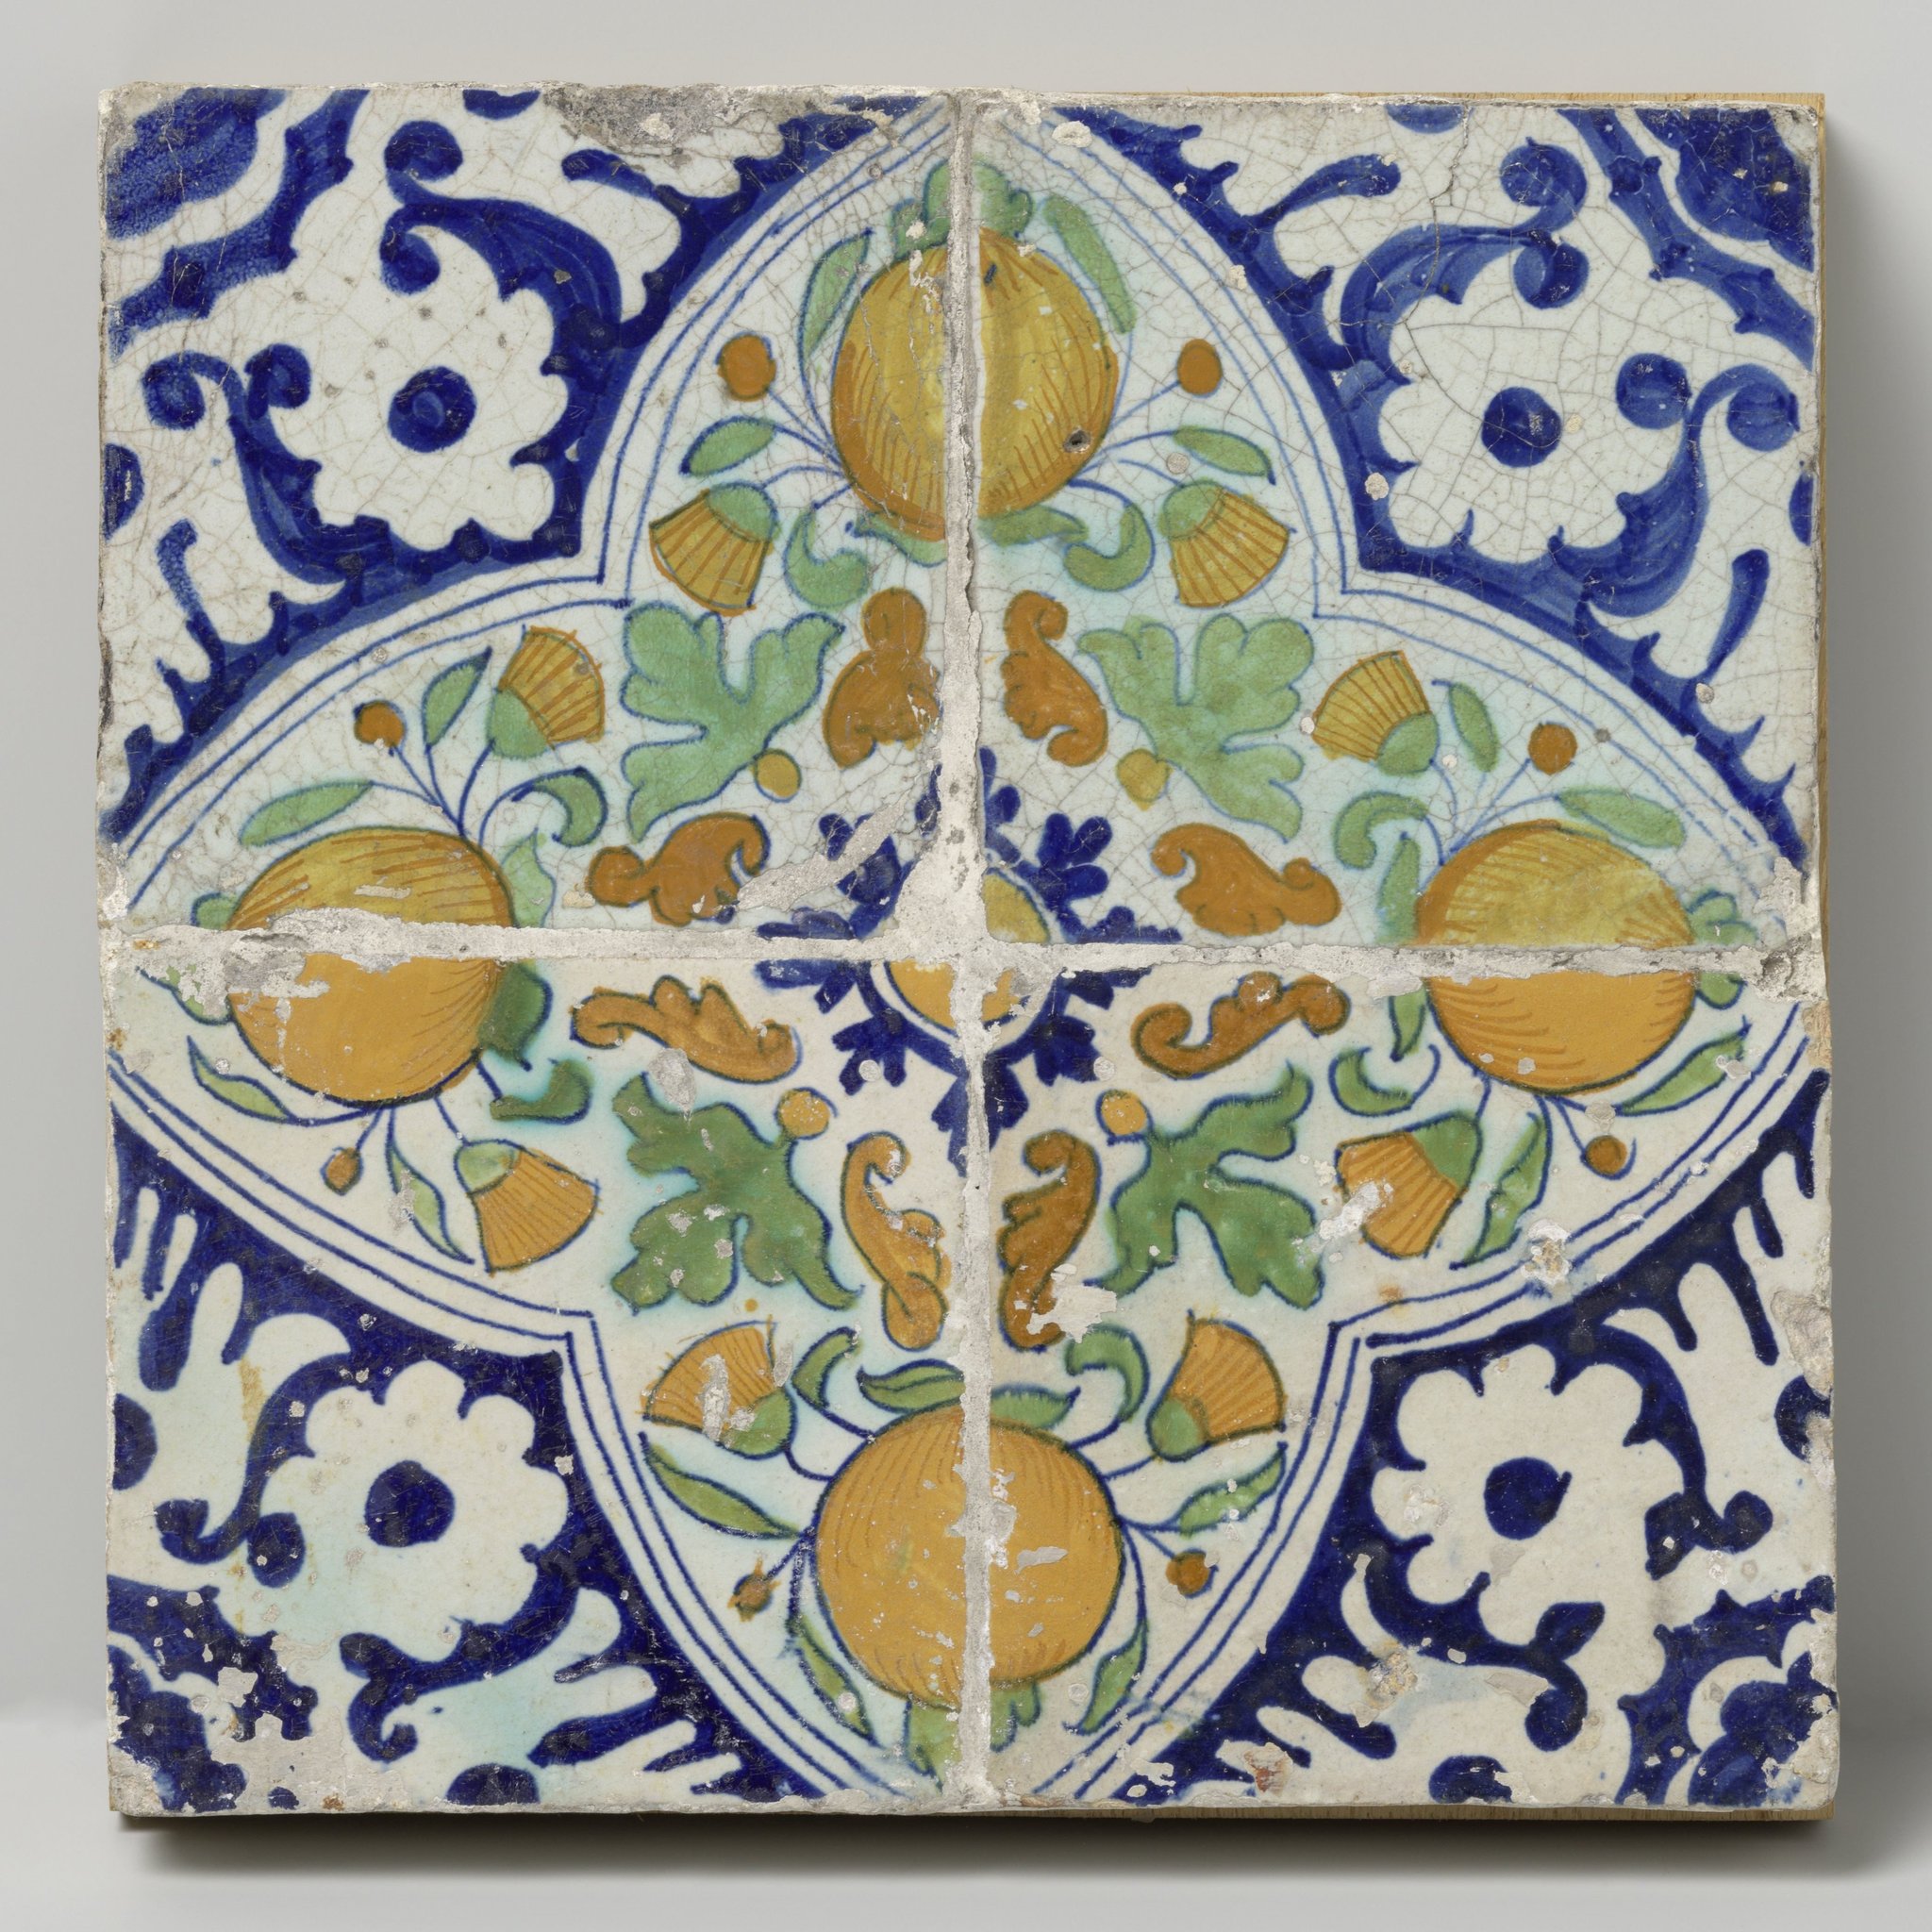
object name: tegelveld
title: Veld van vier tegels met oranjeappels en goudsbloemen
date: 1400-1950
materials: earthenware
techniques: maiolica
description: Veld van vier tegels (2x2), tezamen een vierpas vormend, waarin oranjeappels en goudsbloemen.